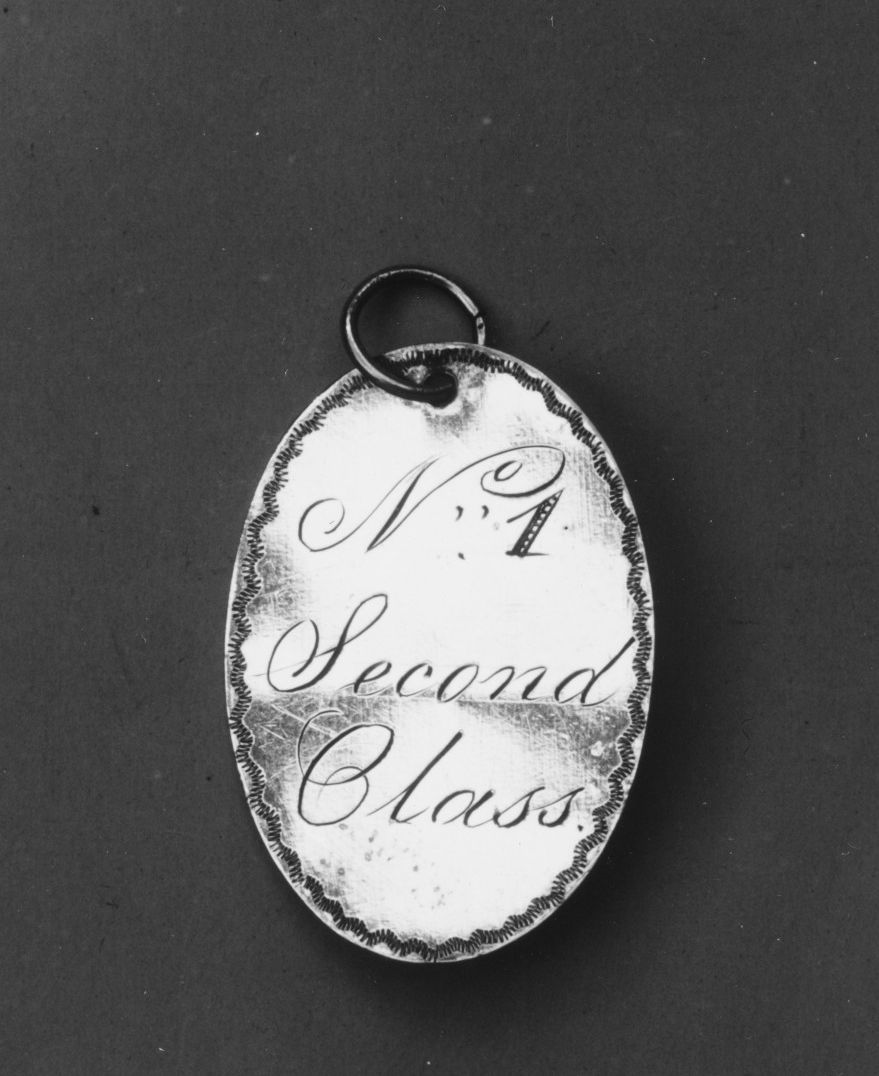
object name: medal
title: Scholarship Medal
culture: american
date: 1800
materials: silver